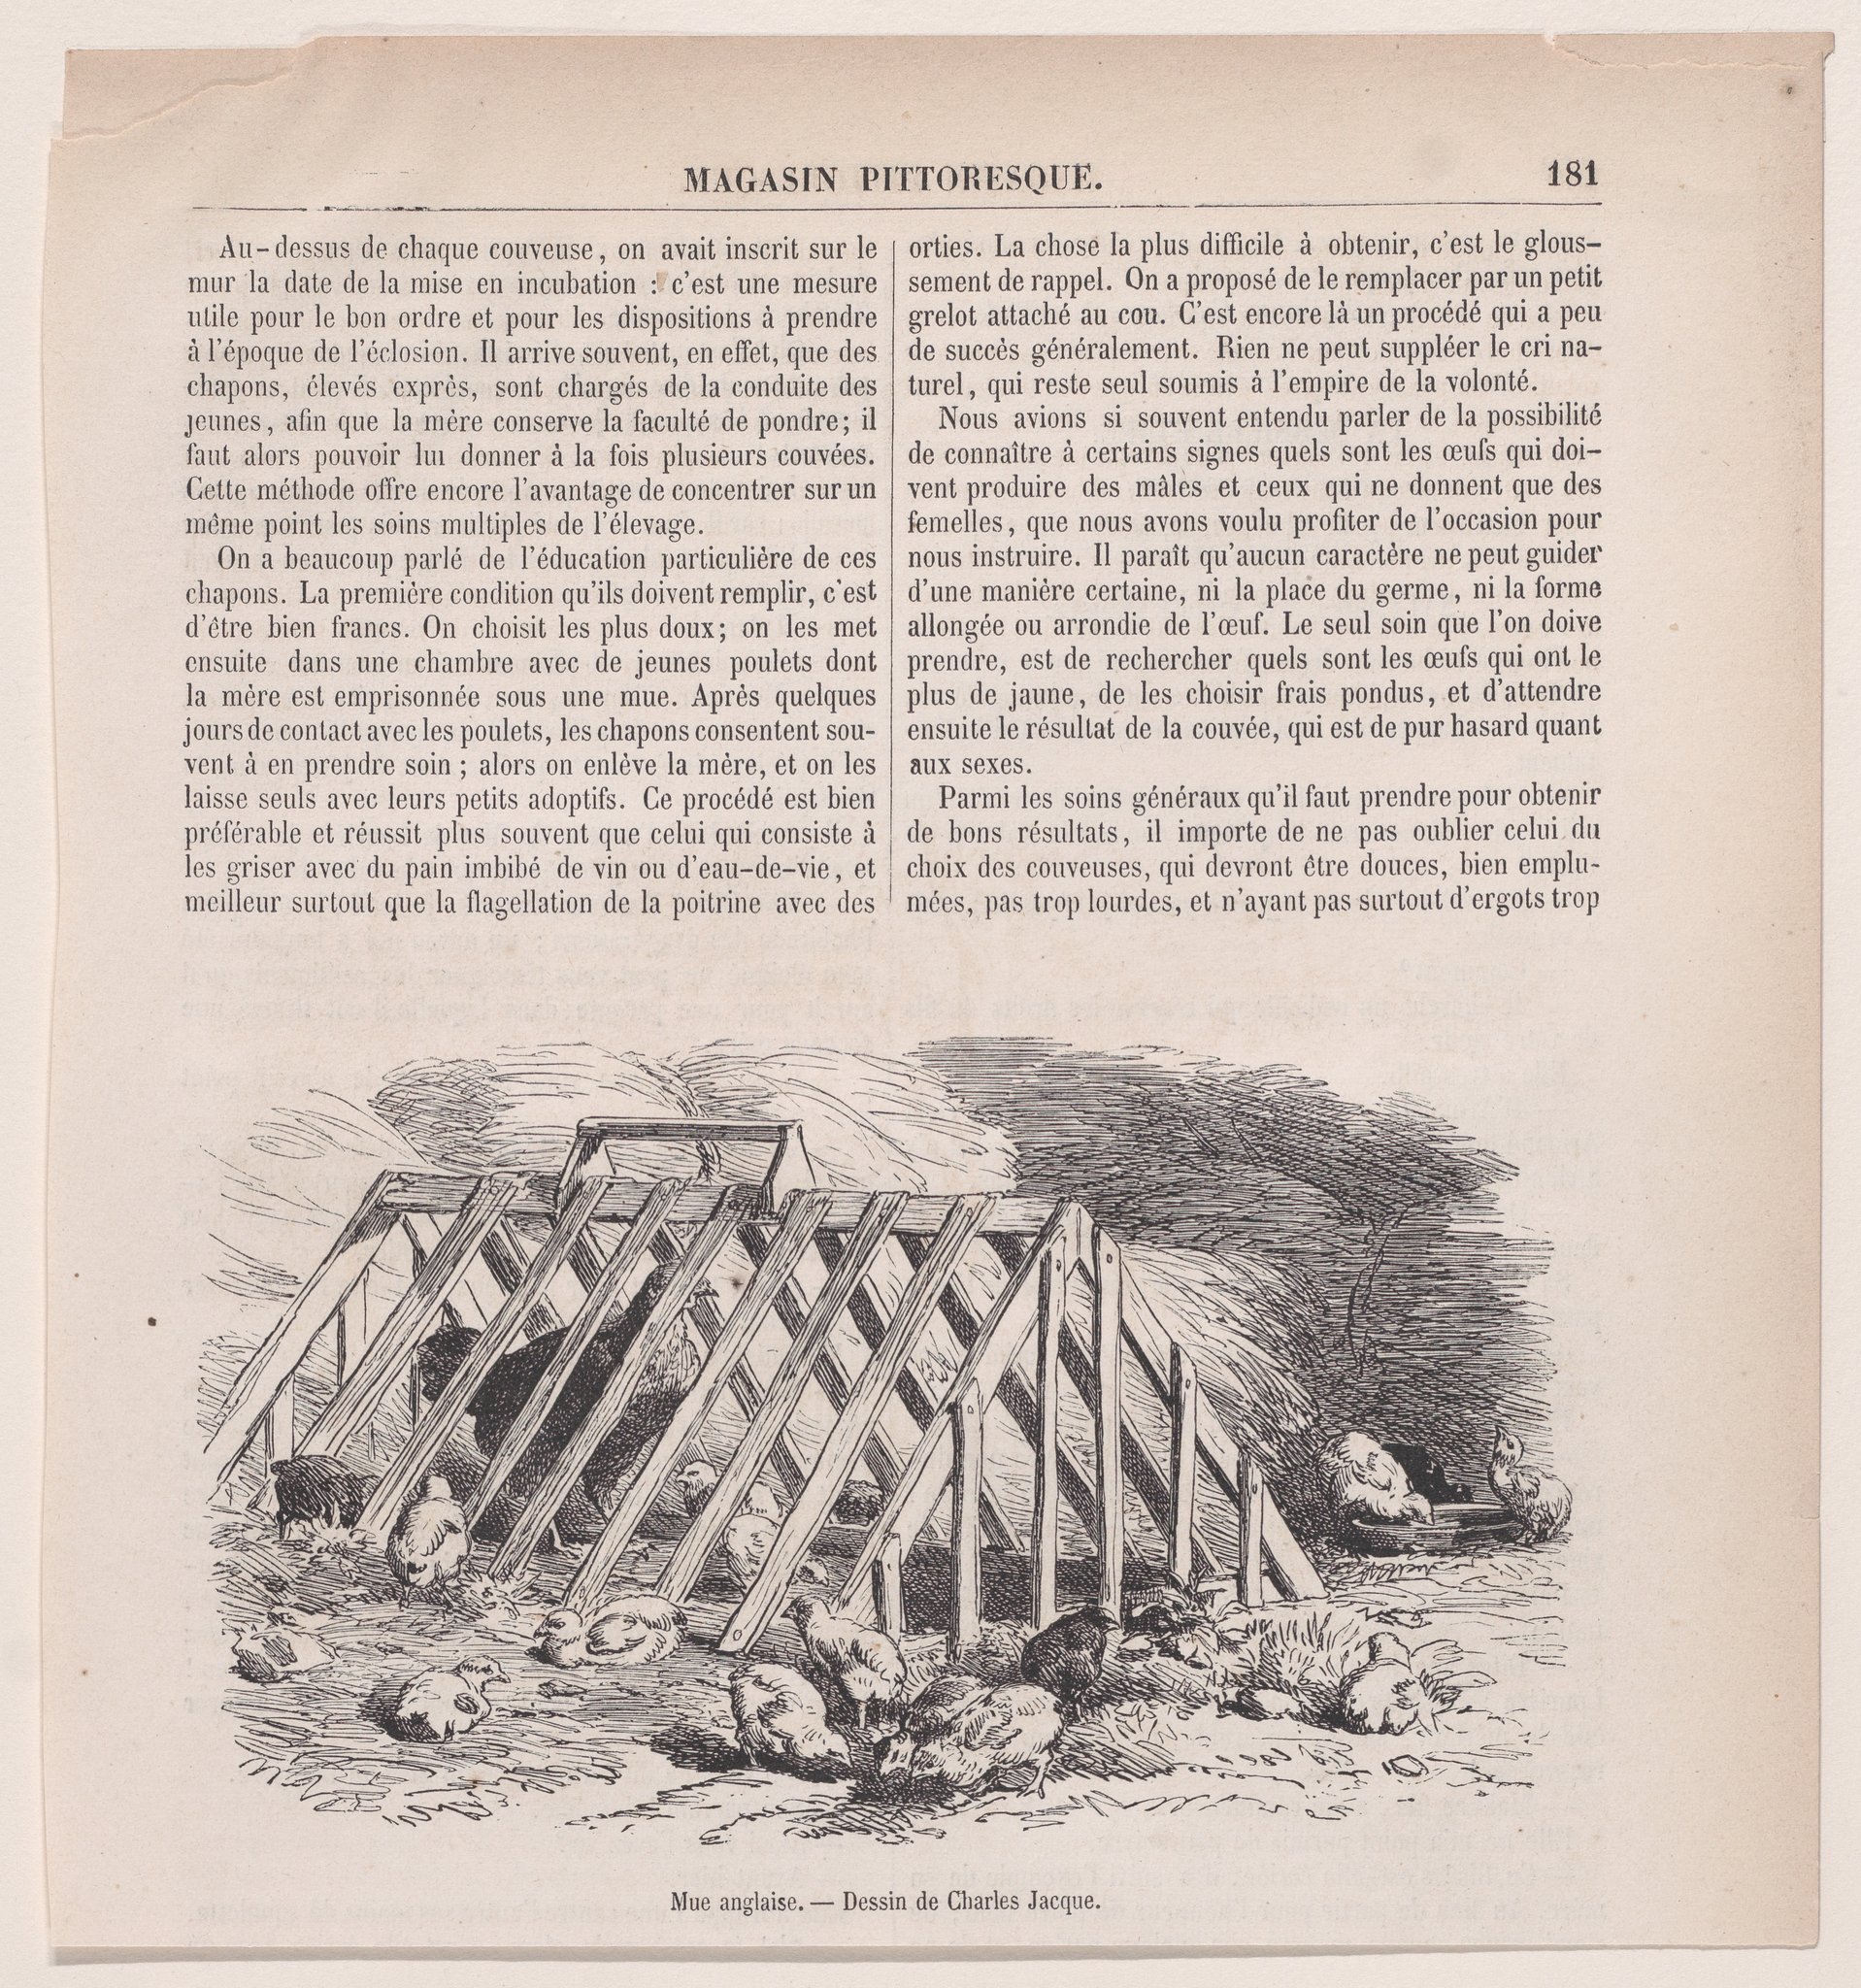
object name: print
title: Mue anglaise, from "Le Magasin Pittoresque"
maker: charles émile jacque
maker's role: artist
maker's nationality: french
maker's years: 1813-1894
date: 1852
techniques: engraving